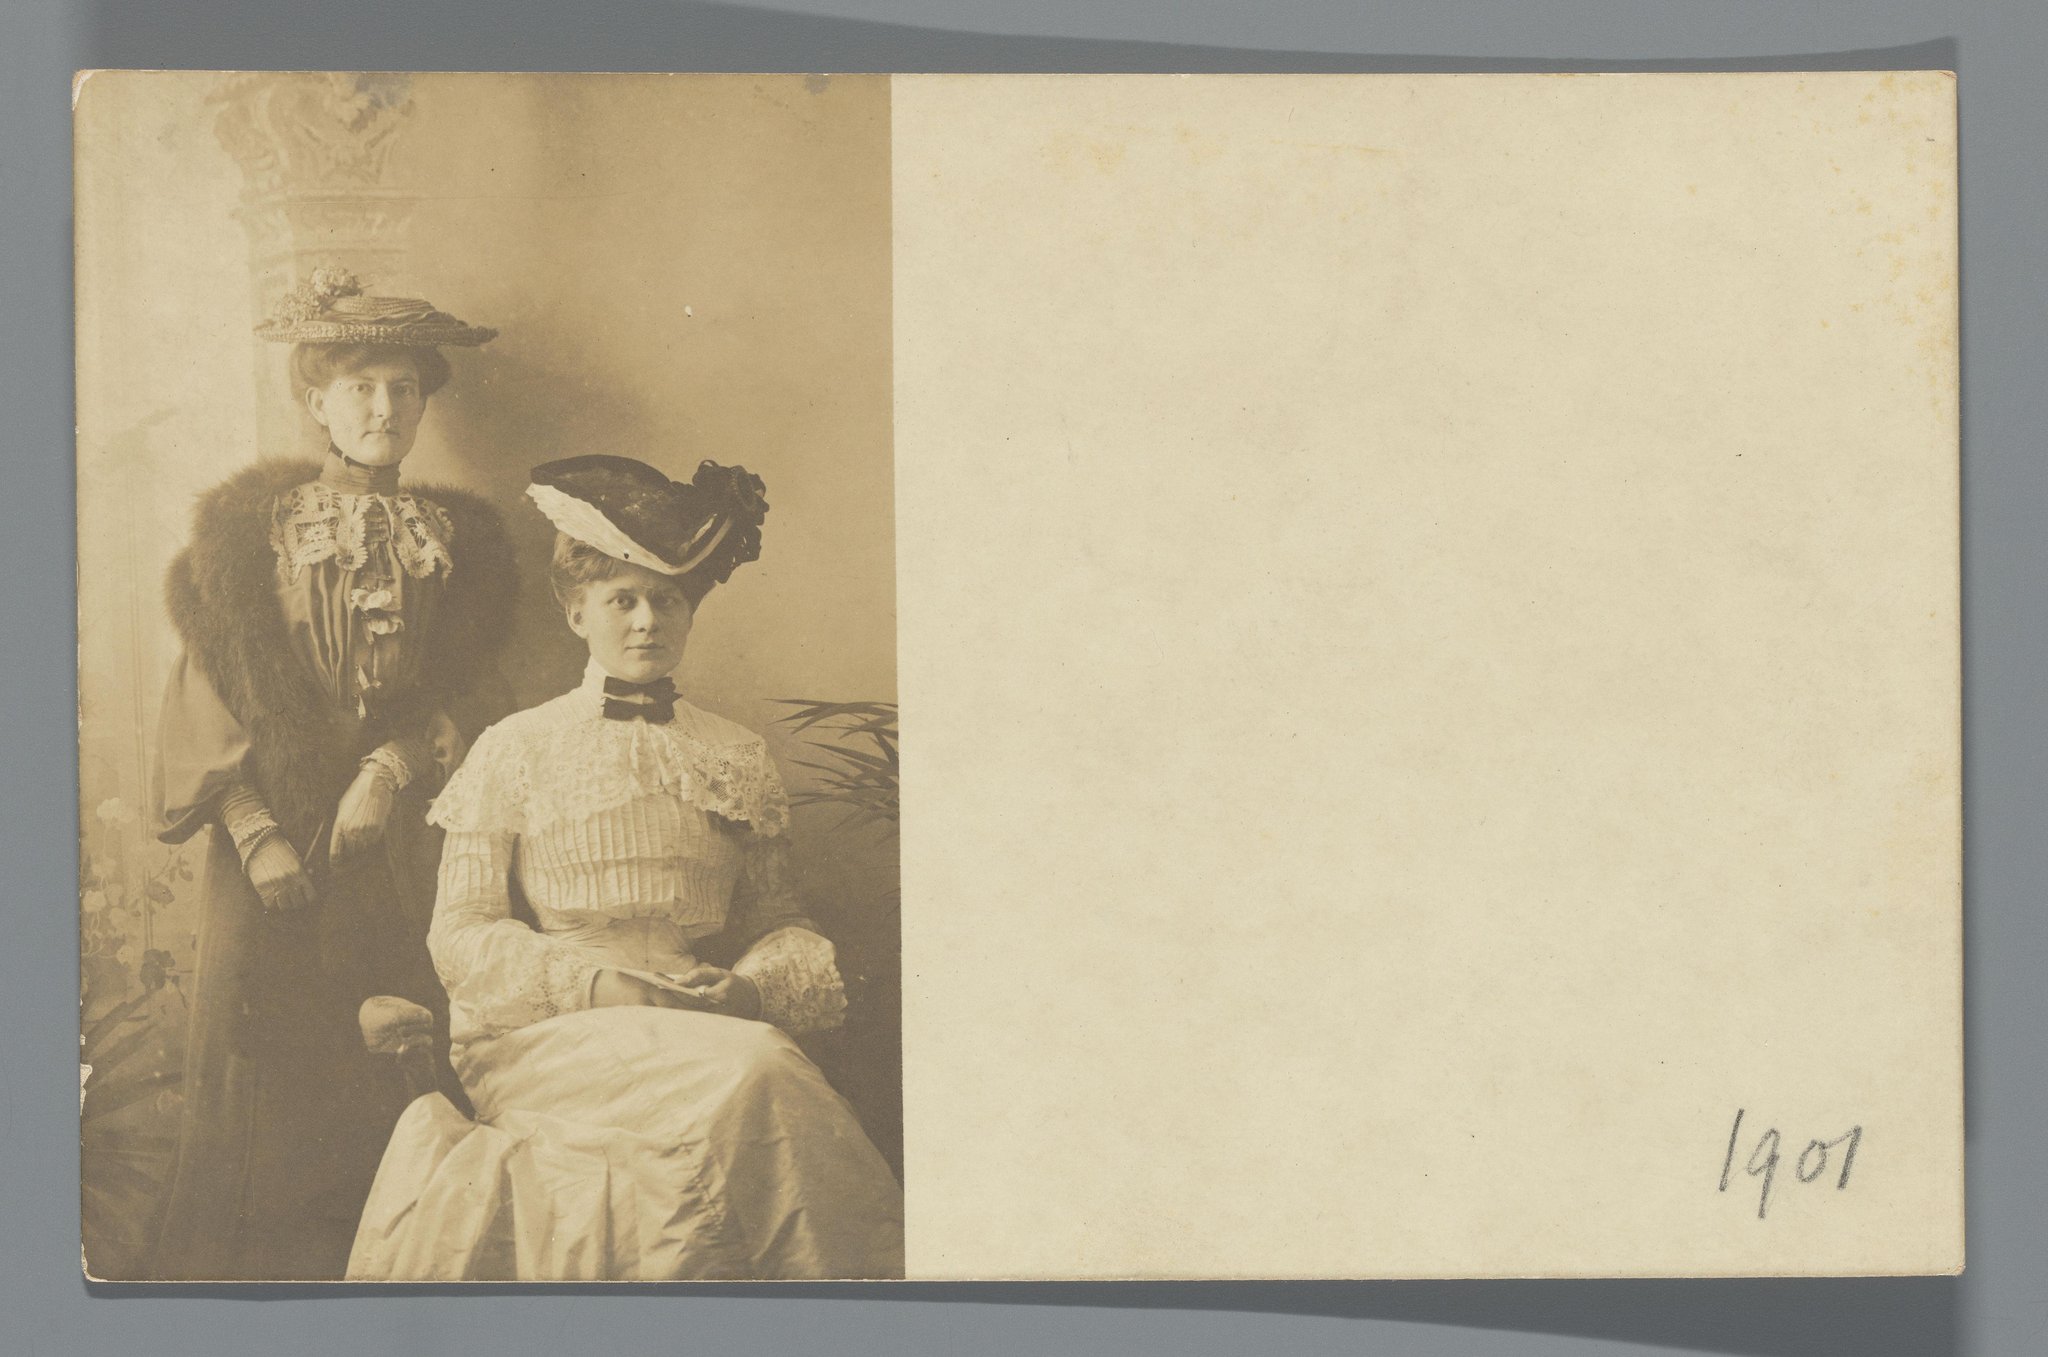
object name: photograph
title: Jo Gijzelman en Line van den Berg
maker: Anonymous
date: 1901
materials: photographic support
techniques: photography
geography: netherlands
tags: the hague, caroline louise van den berg-van den berg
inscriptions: date: ‘1901’, inscription: ‘Jo Gijzelman / Line / 1901 / den Haag’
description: Twee vrouwen met hoeden, de linker staand (Jo) en de rechter zittend (Line).